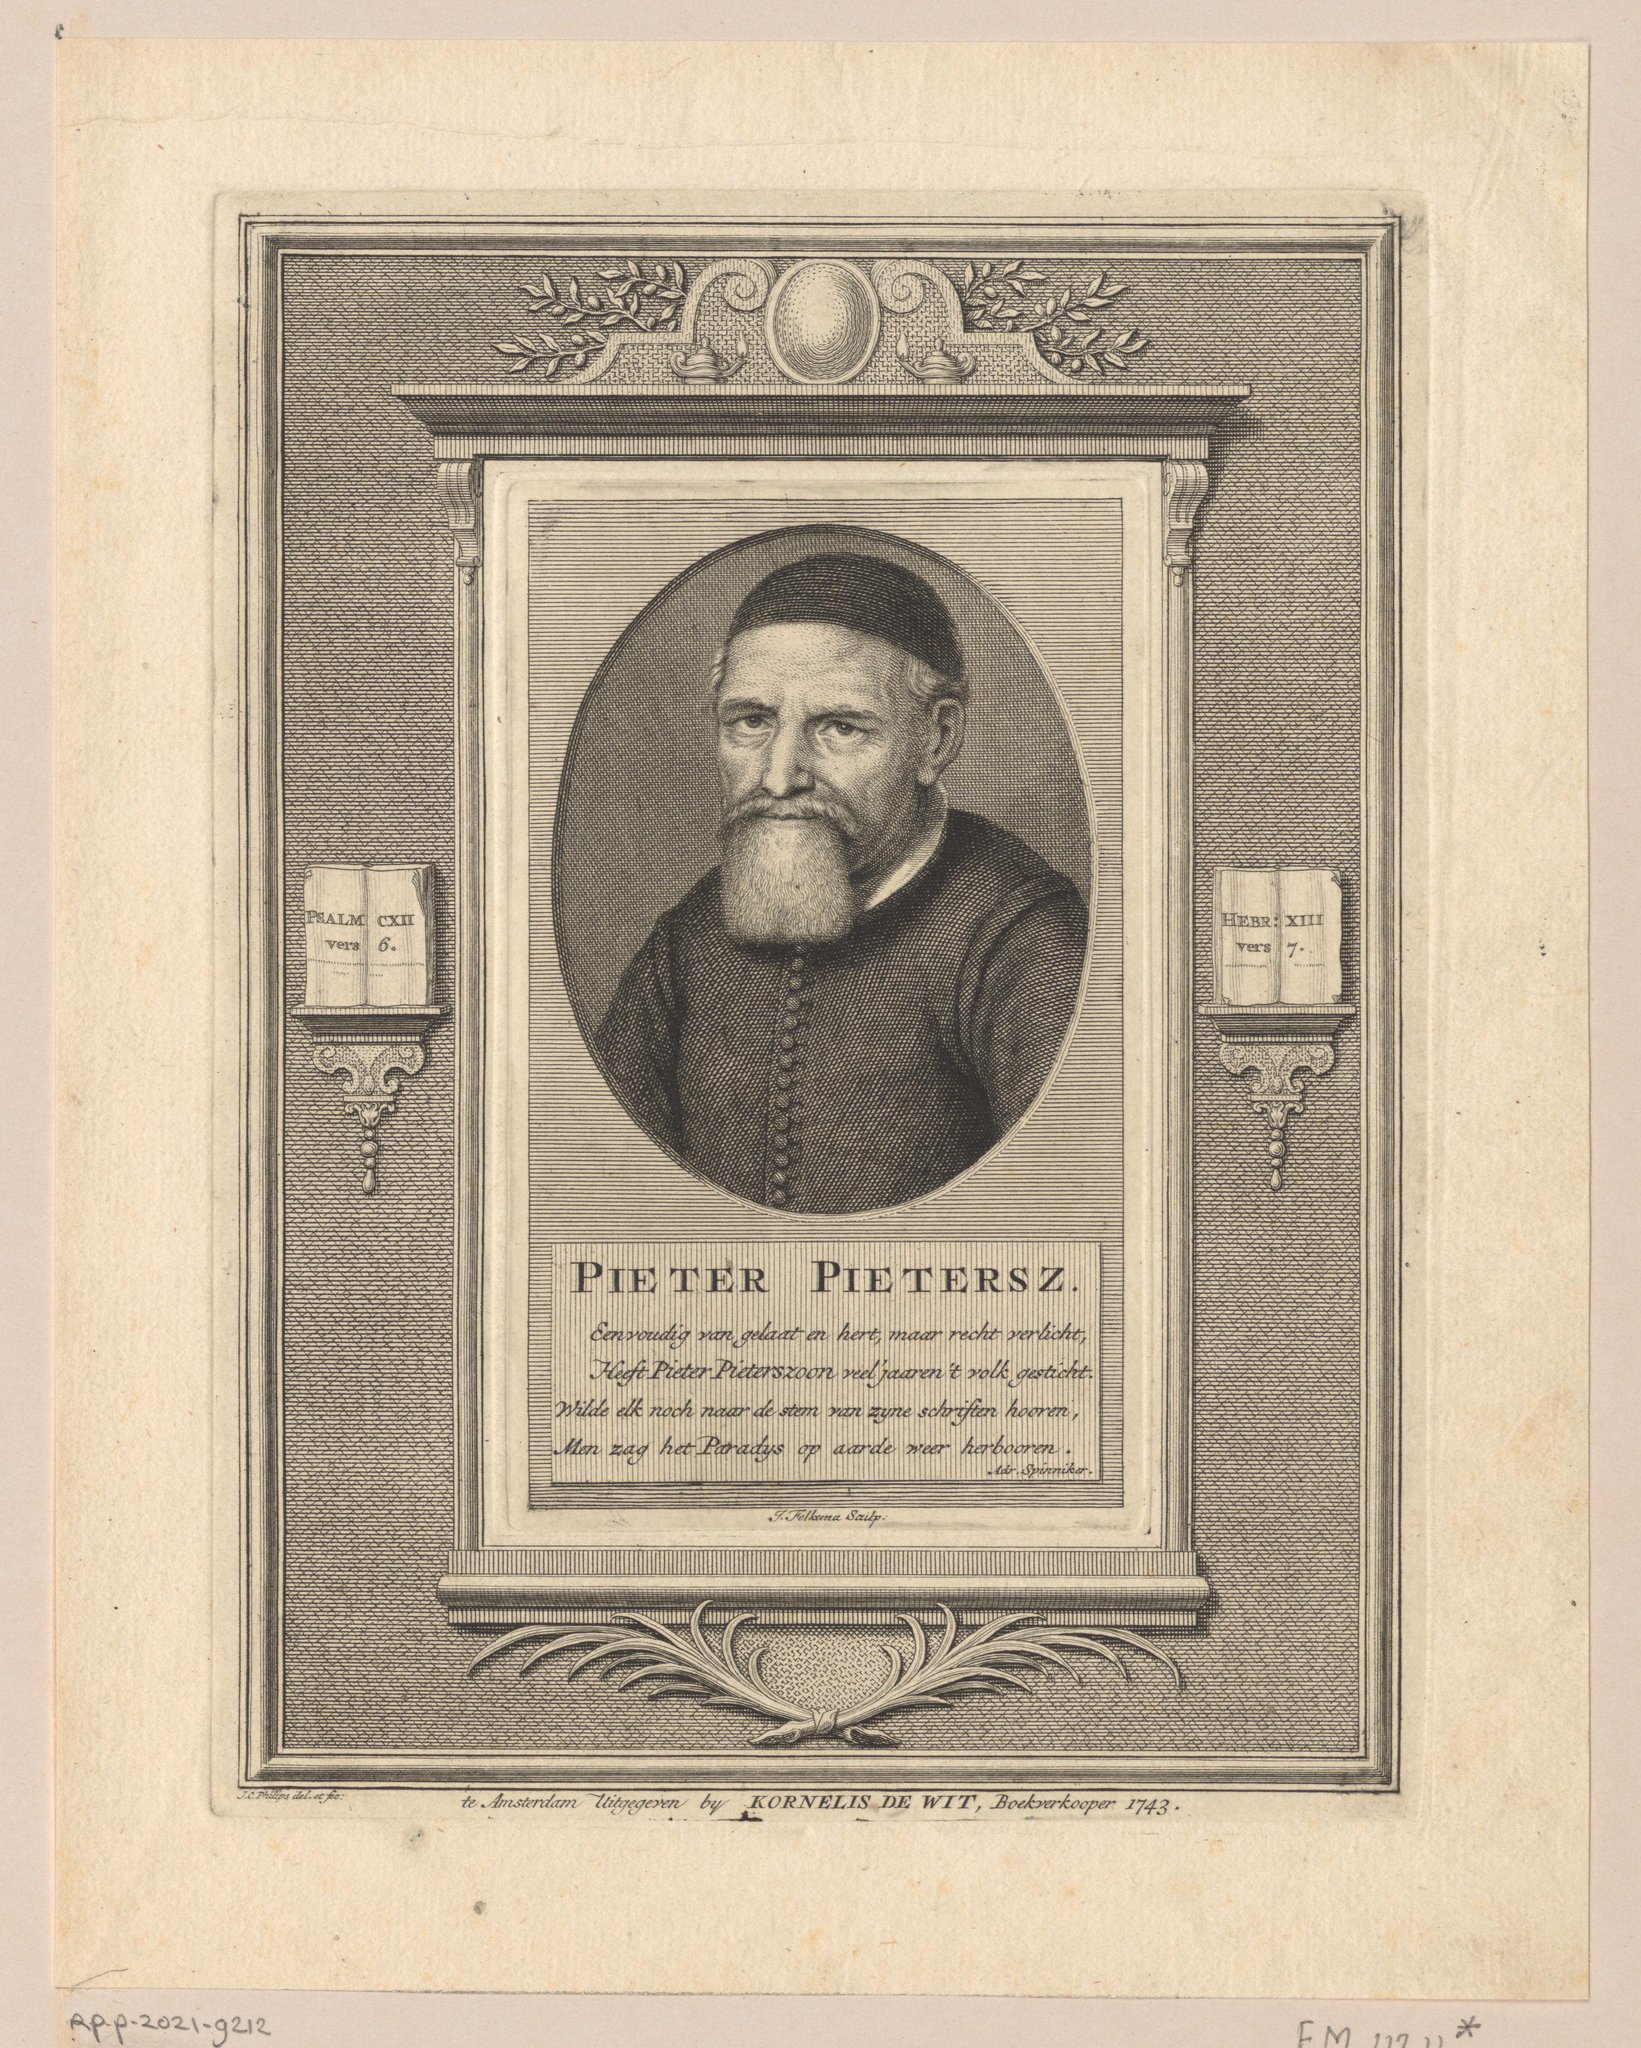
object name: print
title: Verzaameling van de afbeeldingen van veele voornaame mannen en leraaren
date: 1743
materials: paper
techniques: engraving, etching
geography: amsterdam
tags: adult man, historical persons, the bible as a book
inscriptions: date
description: Prent waarschijnlijk uit: Verzaameling van de afbeeldingen van veele voornaame mannen en leeraaren. Amsterdam: Kornelis de Wit, 1743. Prent zonder omlijsting gebruikt in: Schijn, Hermannus. Geschiedenis dier christenen, welke in de Vereenigde Nederlanden onder de protestanten mennoniten genaamd worden. Amsterdam: Kornelis de Wit, 1744, dl. 2.